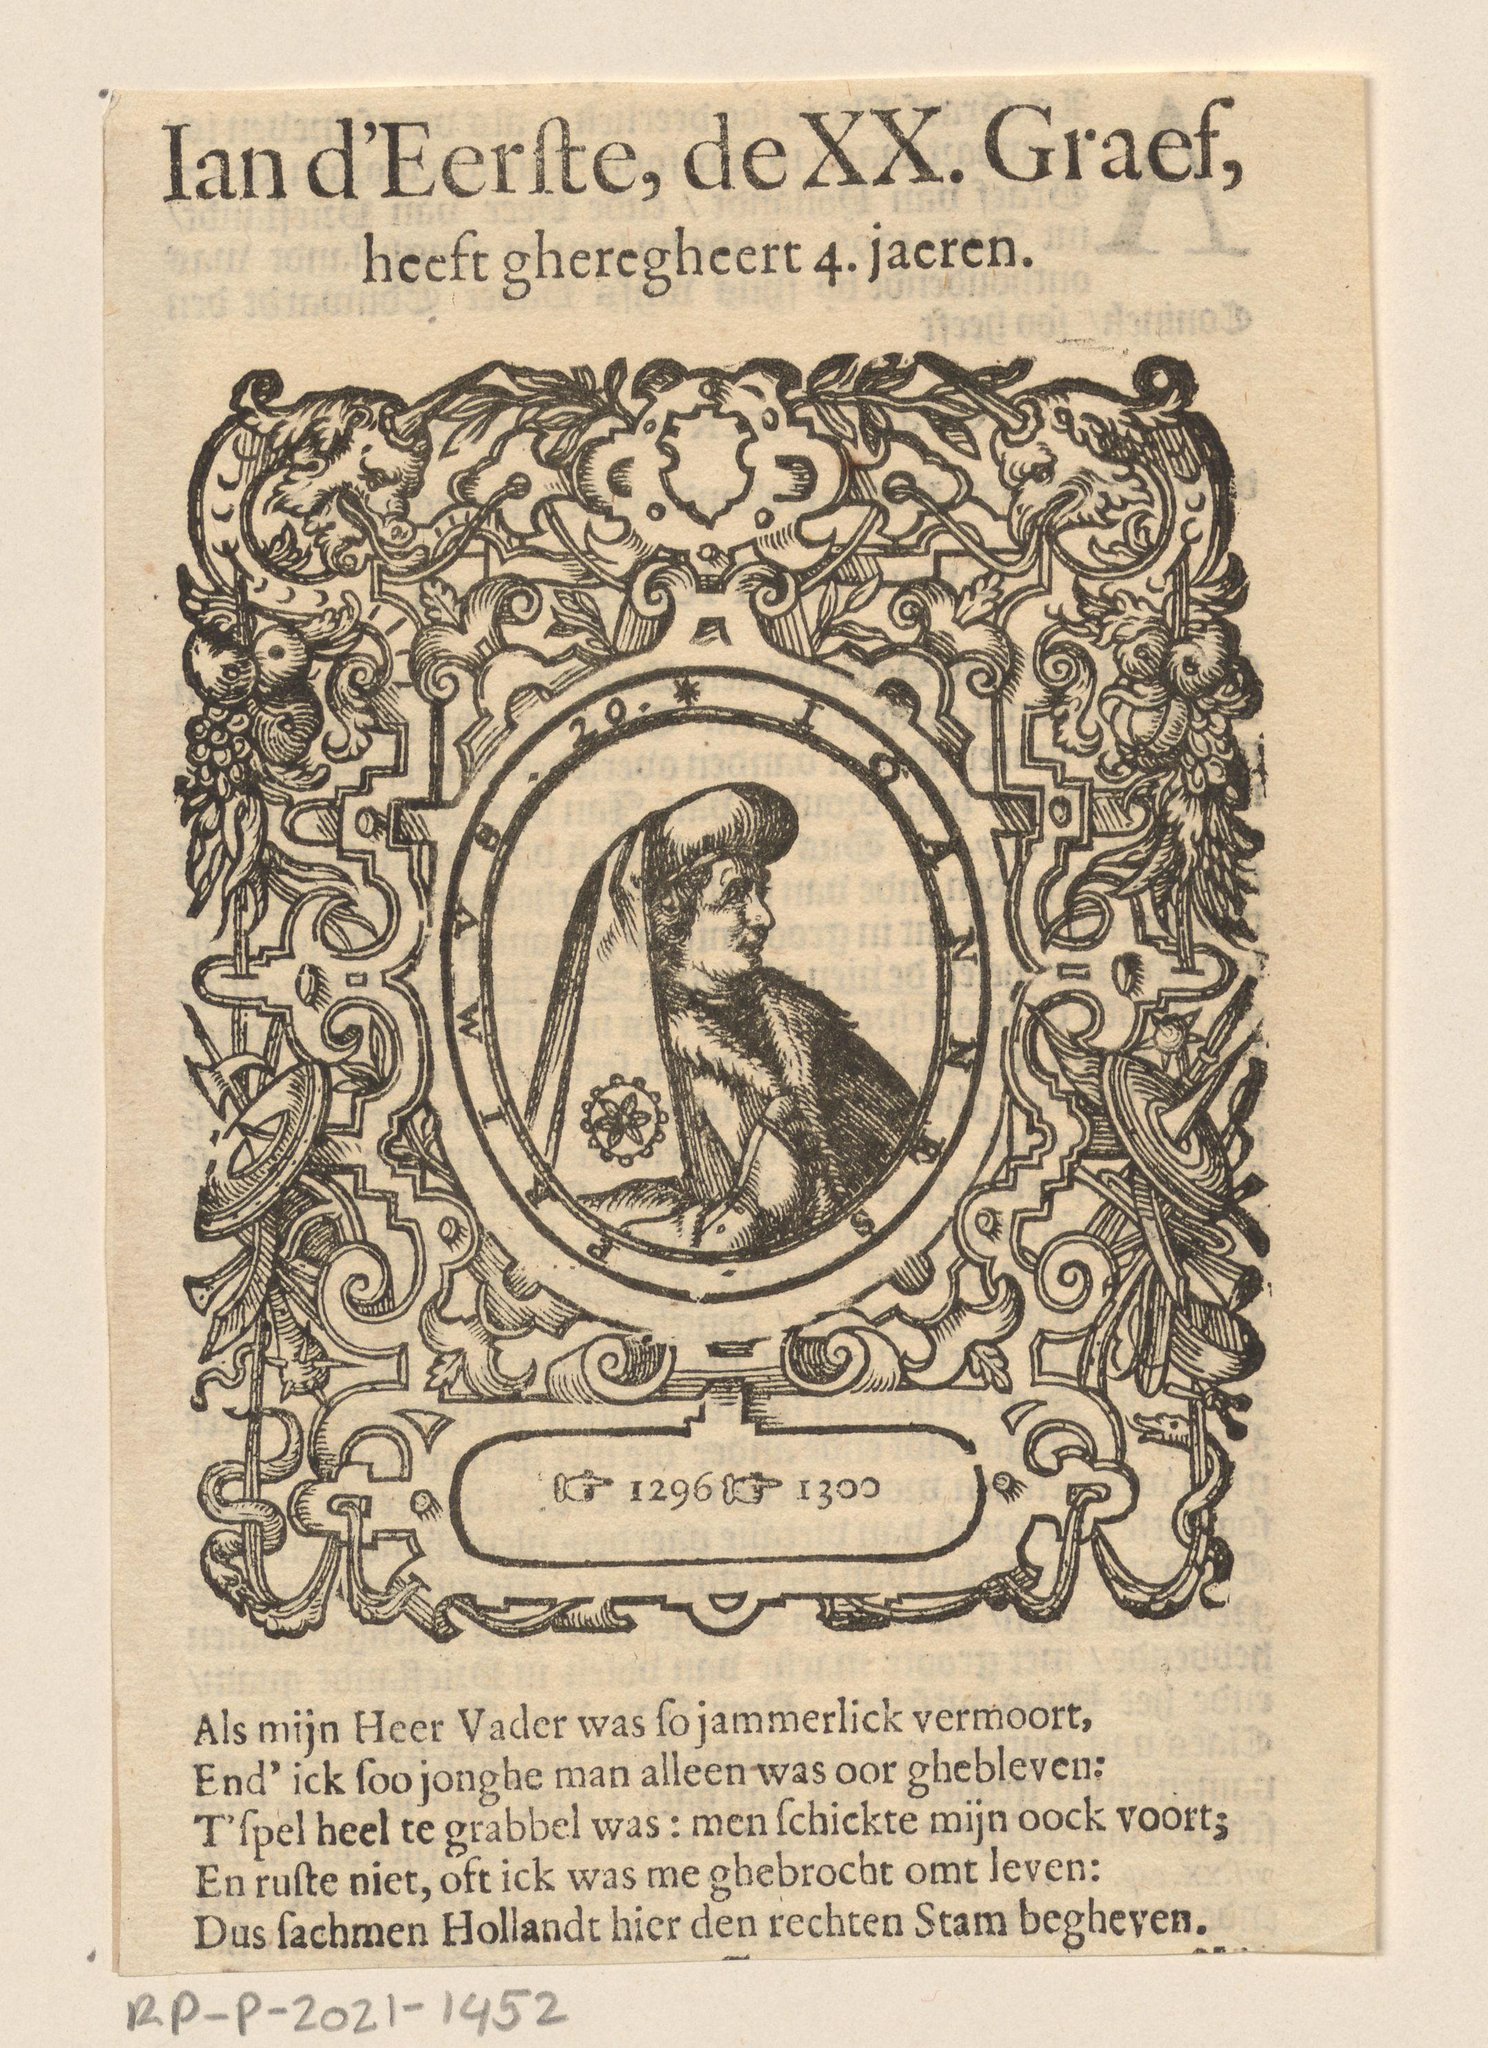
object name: print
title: Portret van Jan I, graaf van Holland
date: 1636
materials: paper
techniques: letterpress printing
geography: amsterdam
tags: jan i (graaf van holland), historical persons, ruler, sovereign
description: Prent uit: Scriverius, Petrus. Beschrivinge van out Batavien met de antiquiteyten vandien (...). Amsterdam: Jan Evertsz Cloppenburgh II, 1636.